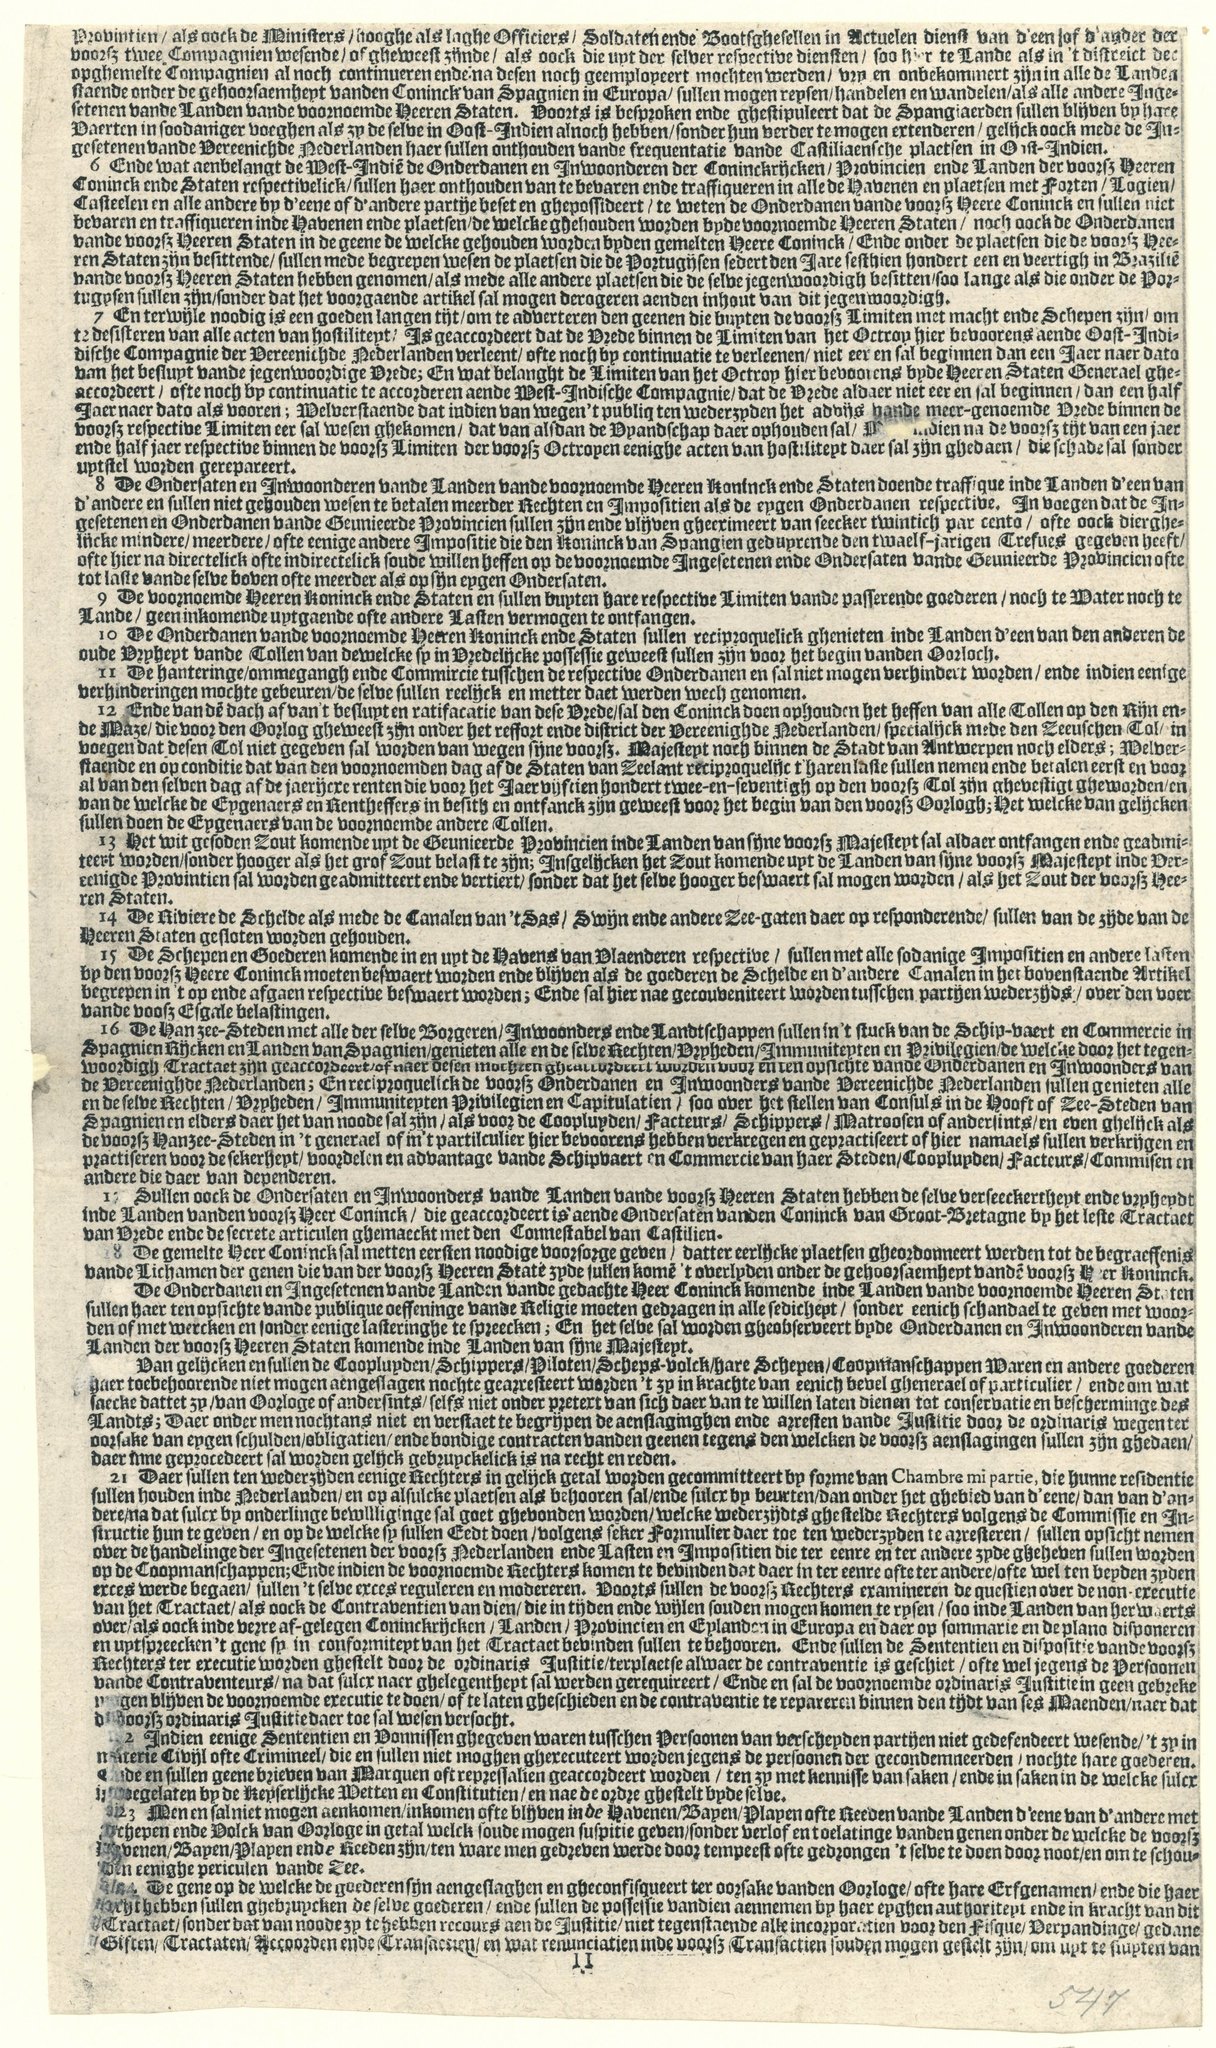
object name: text sheet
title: Traktaat van de Vrede van Munster (tweede blad), 1648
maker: rombout van den hoeye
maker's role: draughtsman, print maker, publisher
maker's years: 1622-1670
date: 1648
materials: paper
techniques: letterpress printing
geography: amsterdam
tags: vrede van münster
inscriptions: date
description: Het traktaat van de Vrede van Munster in 1648; het tweede blad met de artikelen 6-24. Tekst in één kolom in het Nederlands.